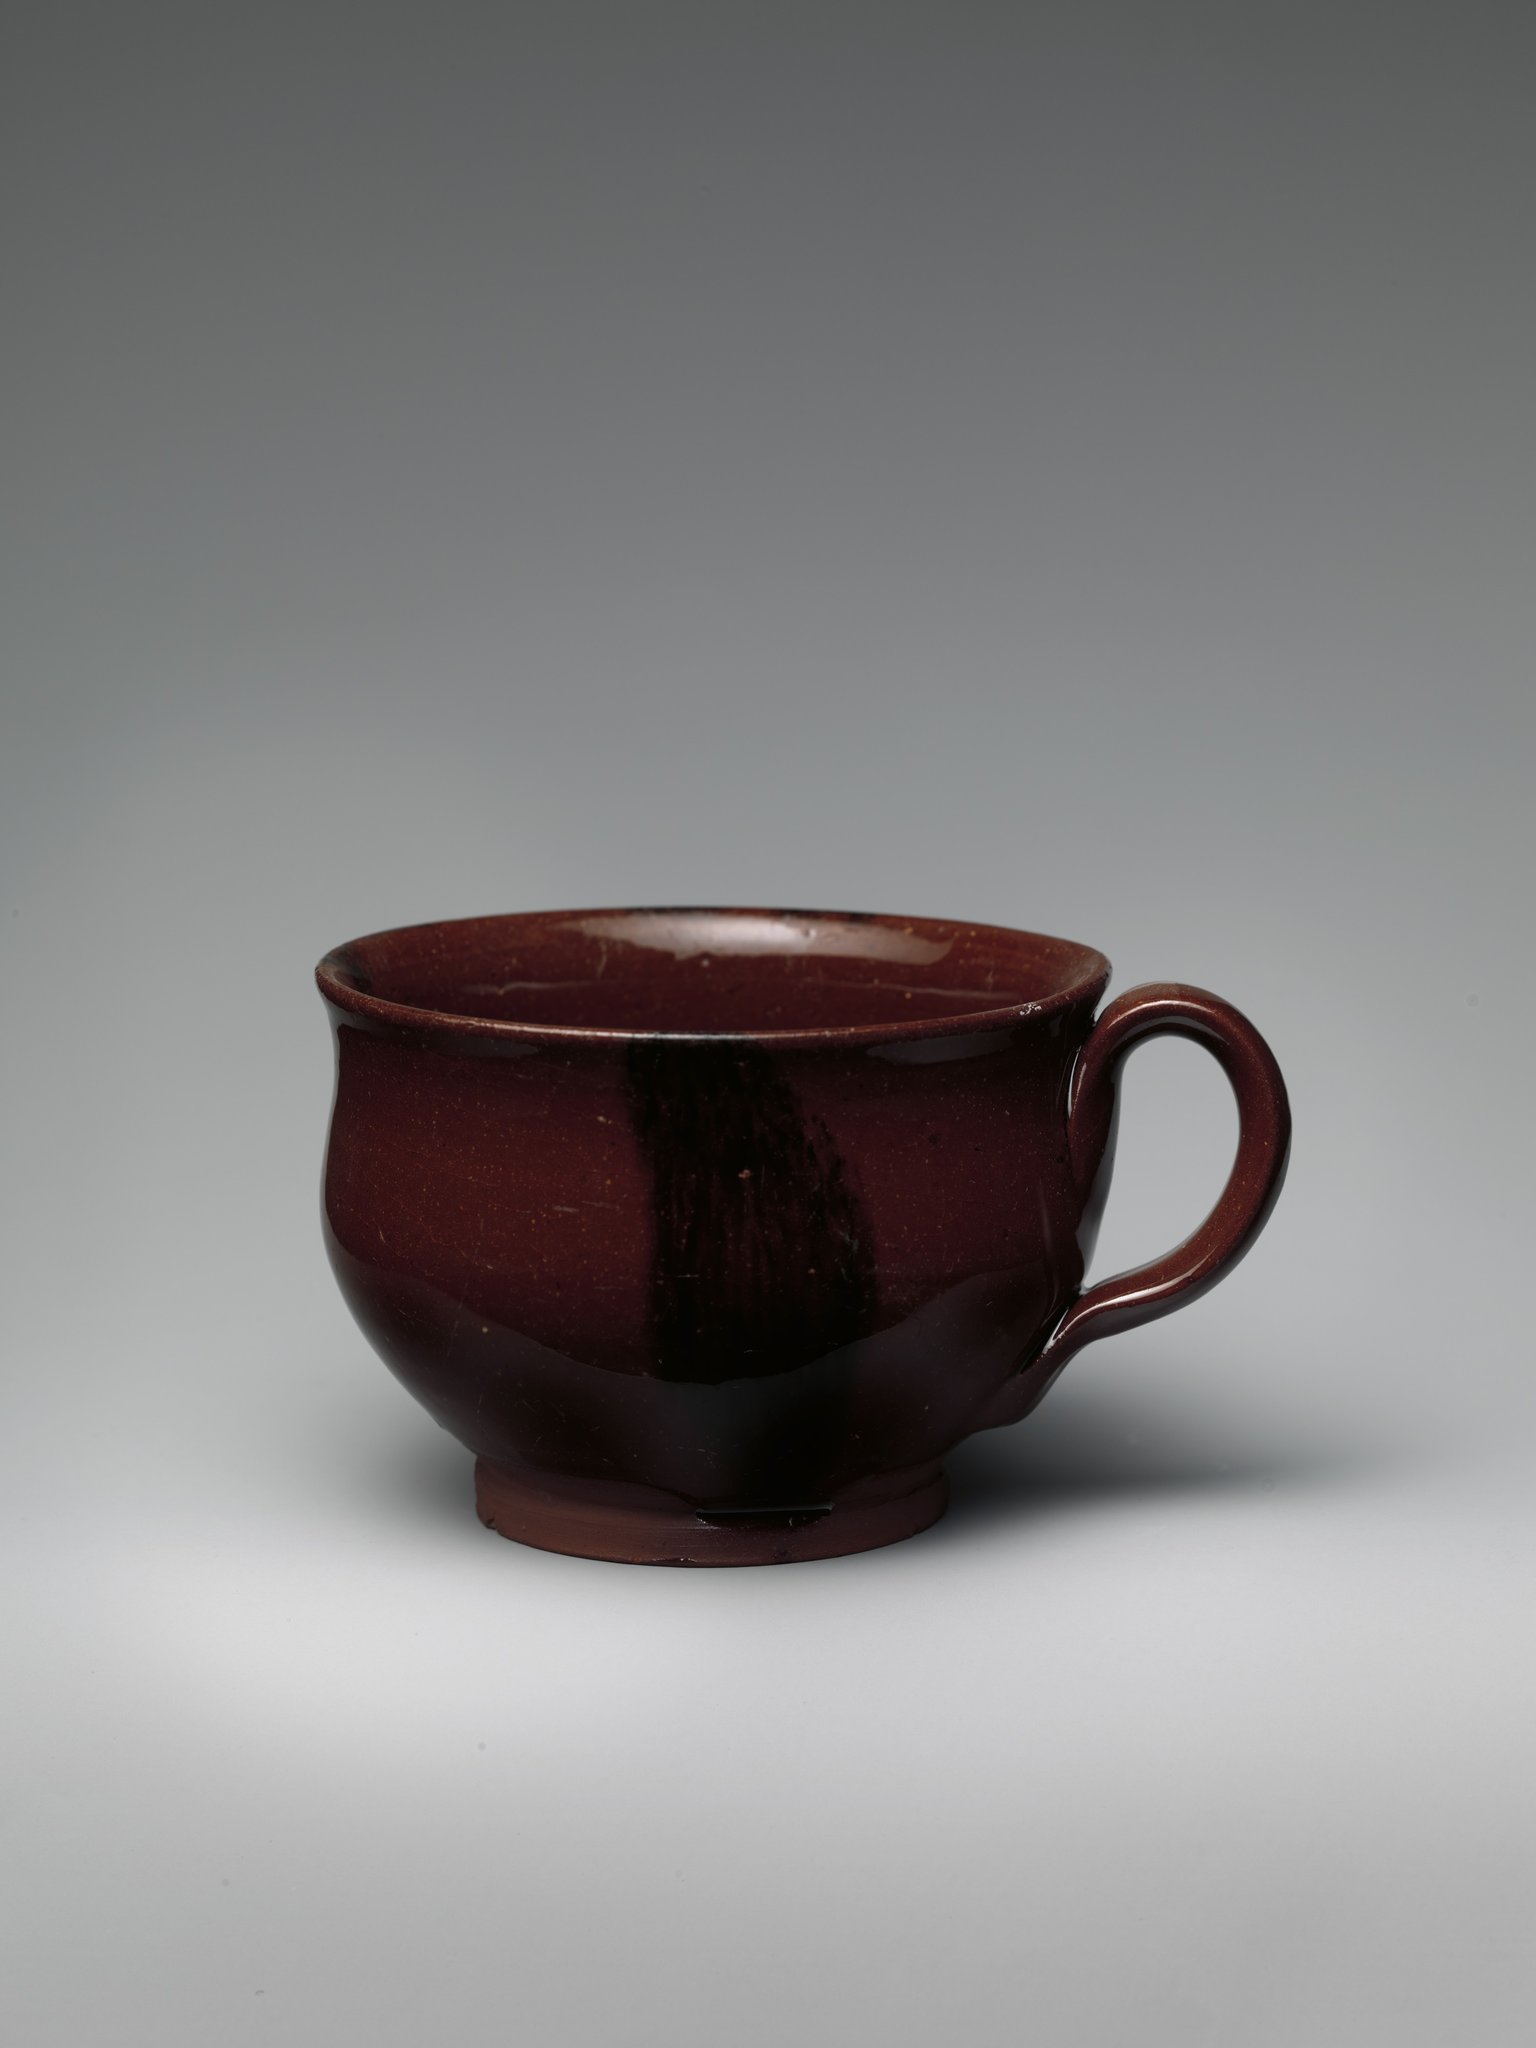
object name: cup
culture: american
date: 1800-1850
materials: earthenware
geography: new england